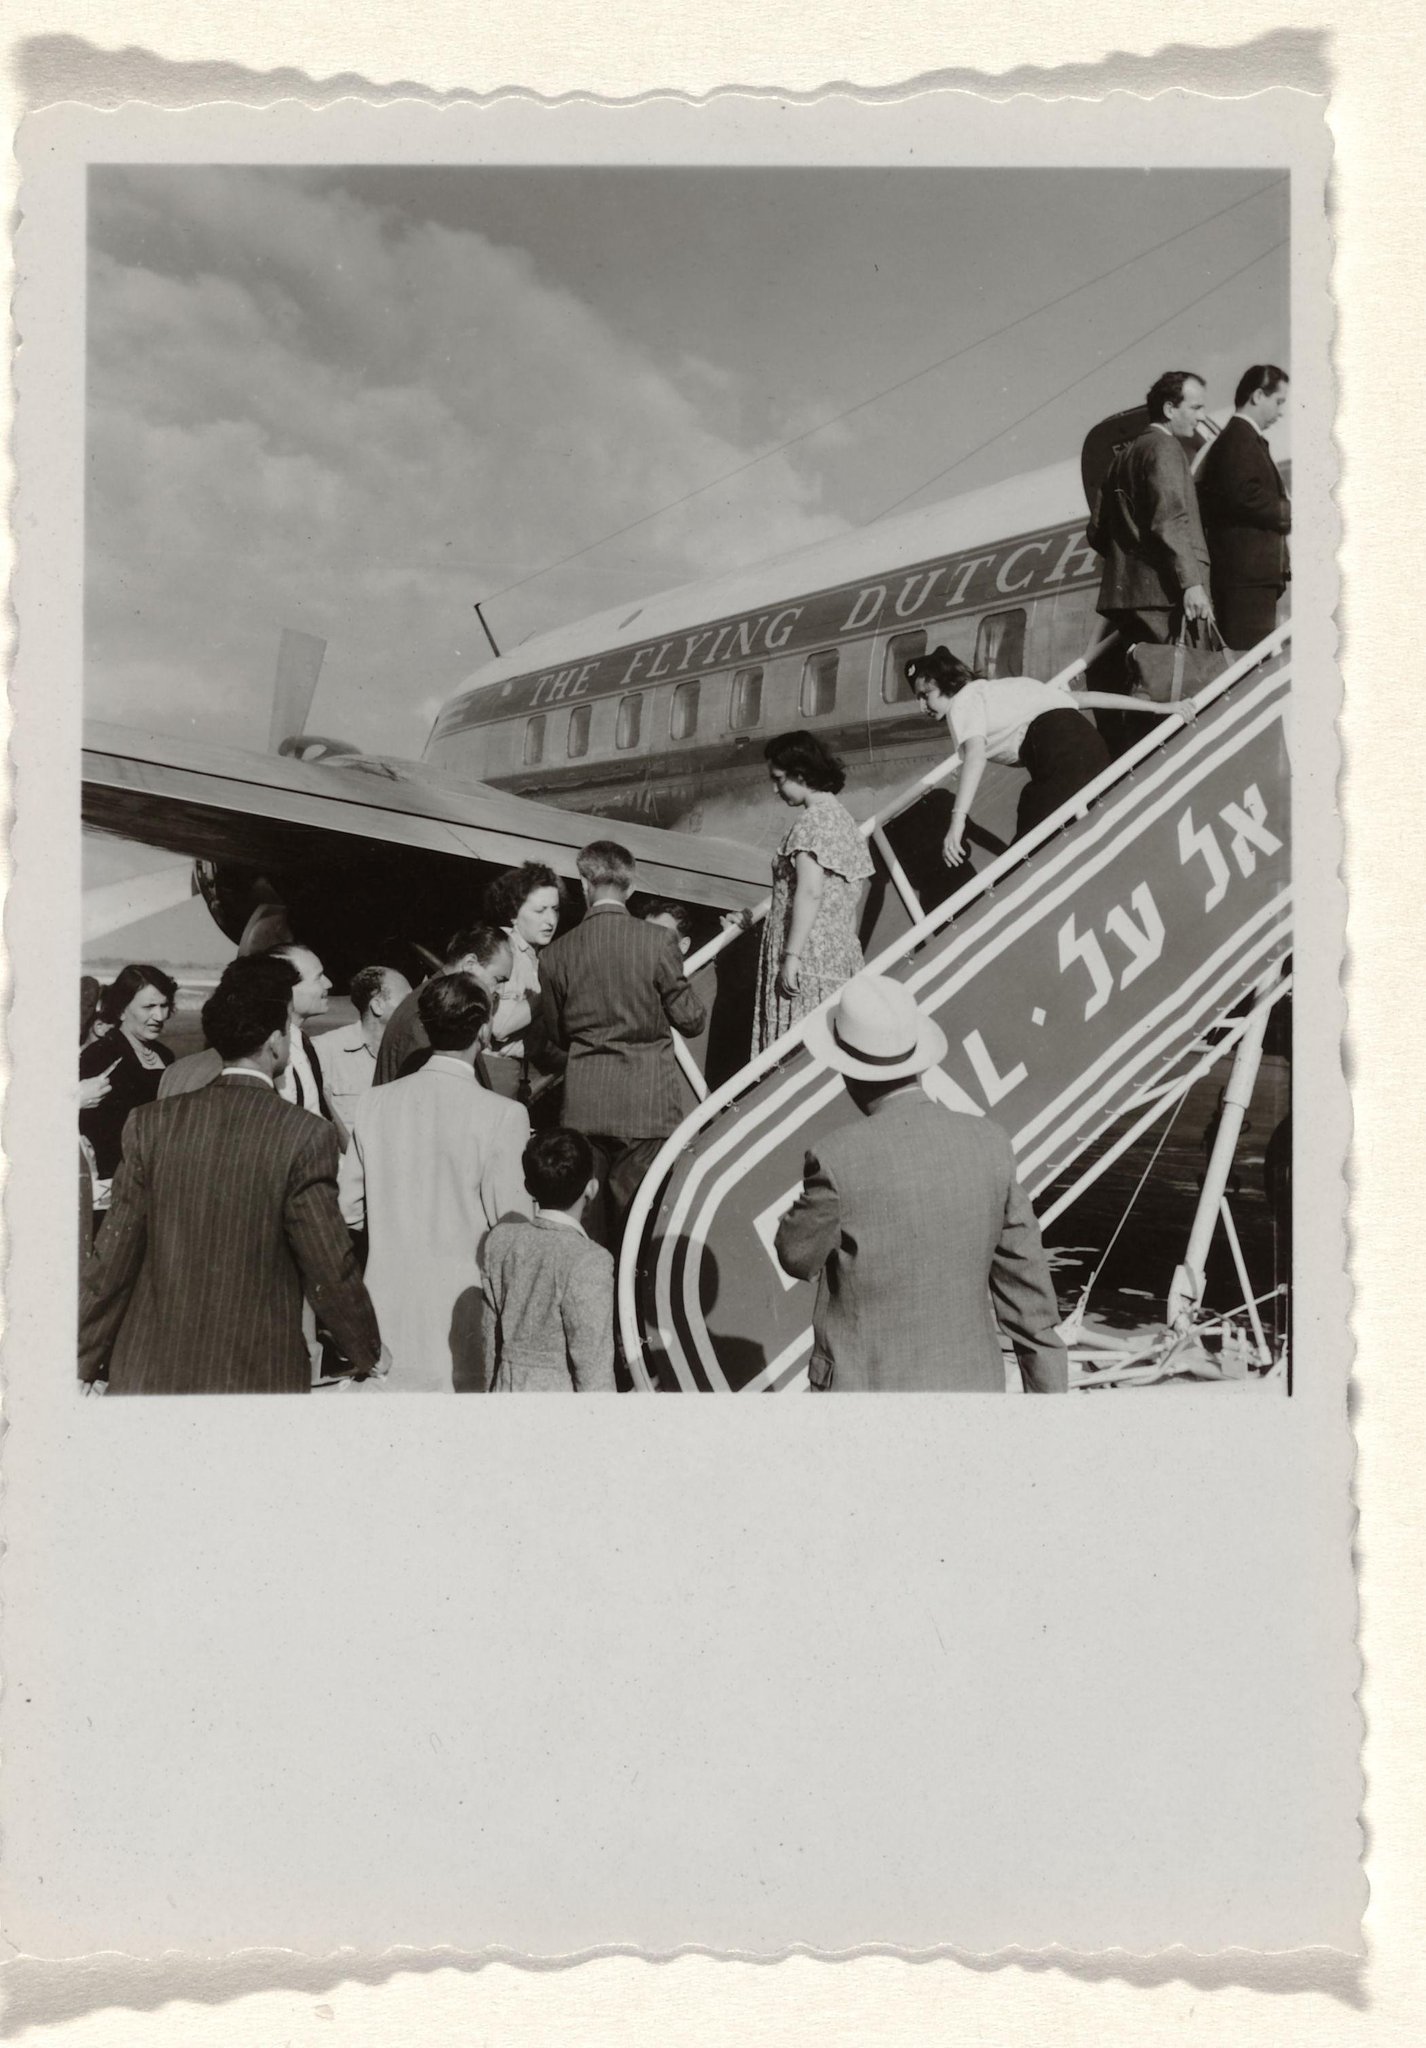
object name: photograph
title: Isabel Wachenheimer staand op de toegangstrap van het KLM-toestel The flying Dutchman met grondpersoneel en passagiers, met Hebreeuwse letters op de trap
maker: Anonymous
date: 1950-1970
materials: photographic support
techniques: gelatin silver print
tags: isabel wachenheimer-elon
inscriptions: number: ‘9’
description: Isabel Wachenheimer staand op de toegangstrap van het KLM-toestel The flying Dutchman met grondpersoneel en passagiers, met Hebreeuwse letters op de trap.